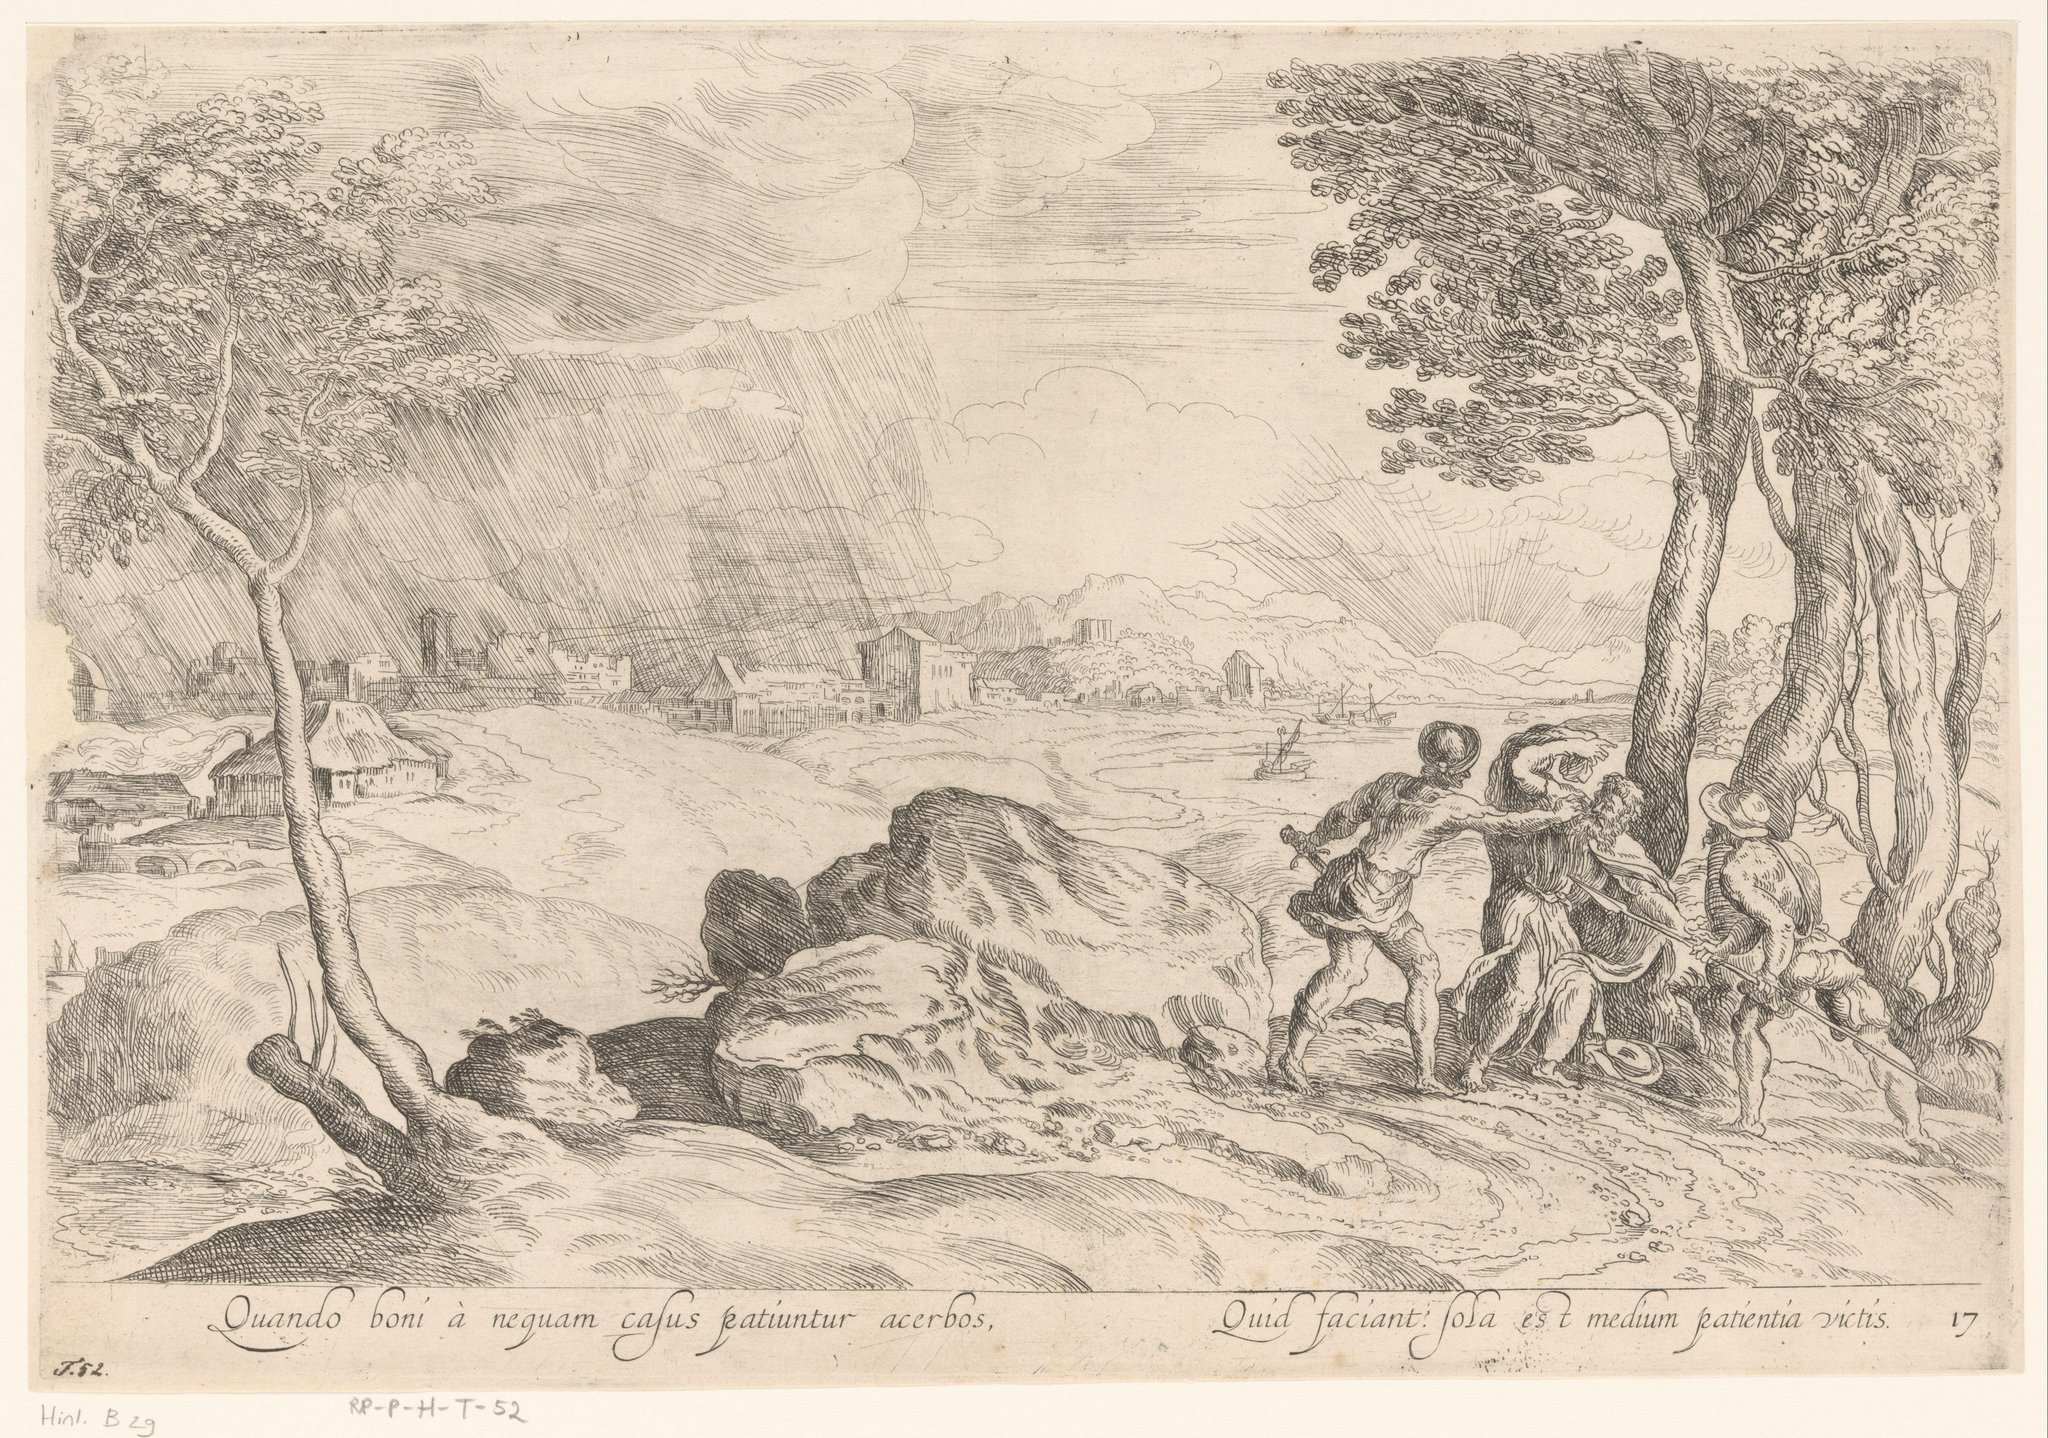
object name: print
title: Landschappen naar Domenico Campagnola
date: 1600-1699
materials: paper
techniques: etching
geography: italy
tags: landscapes, river, traveller(s) attacked by robber(s)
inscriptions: collector's mark: Lugt 11, number: ‘T. 52.’, collector's mark: ‘Hinloopen’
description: Een landschap met een rivier en een dorp links. Op de voorgrond rechts twee rover die een oude man belagen. Titel in het Latijn in ondermarge. Genummerd rechtsonder: 17.